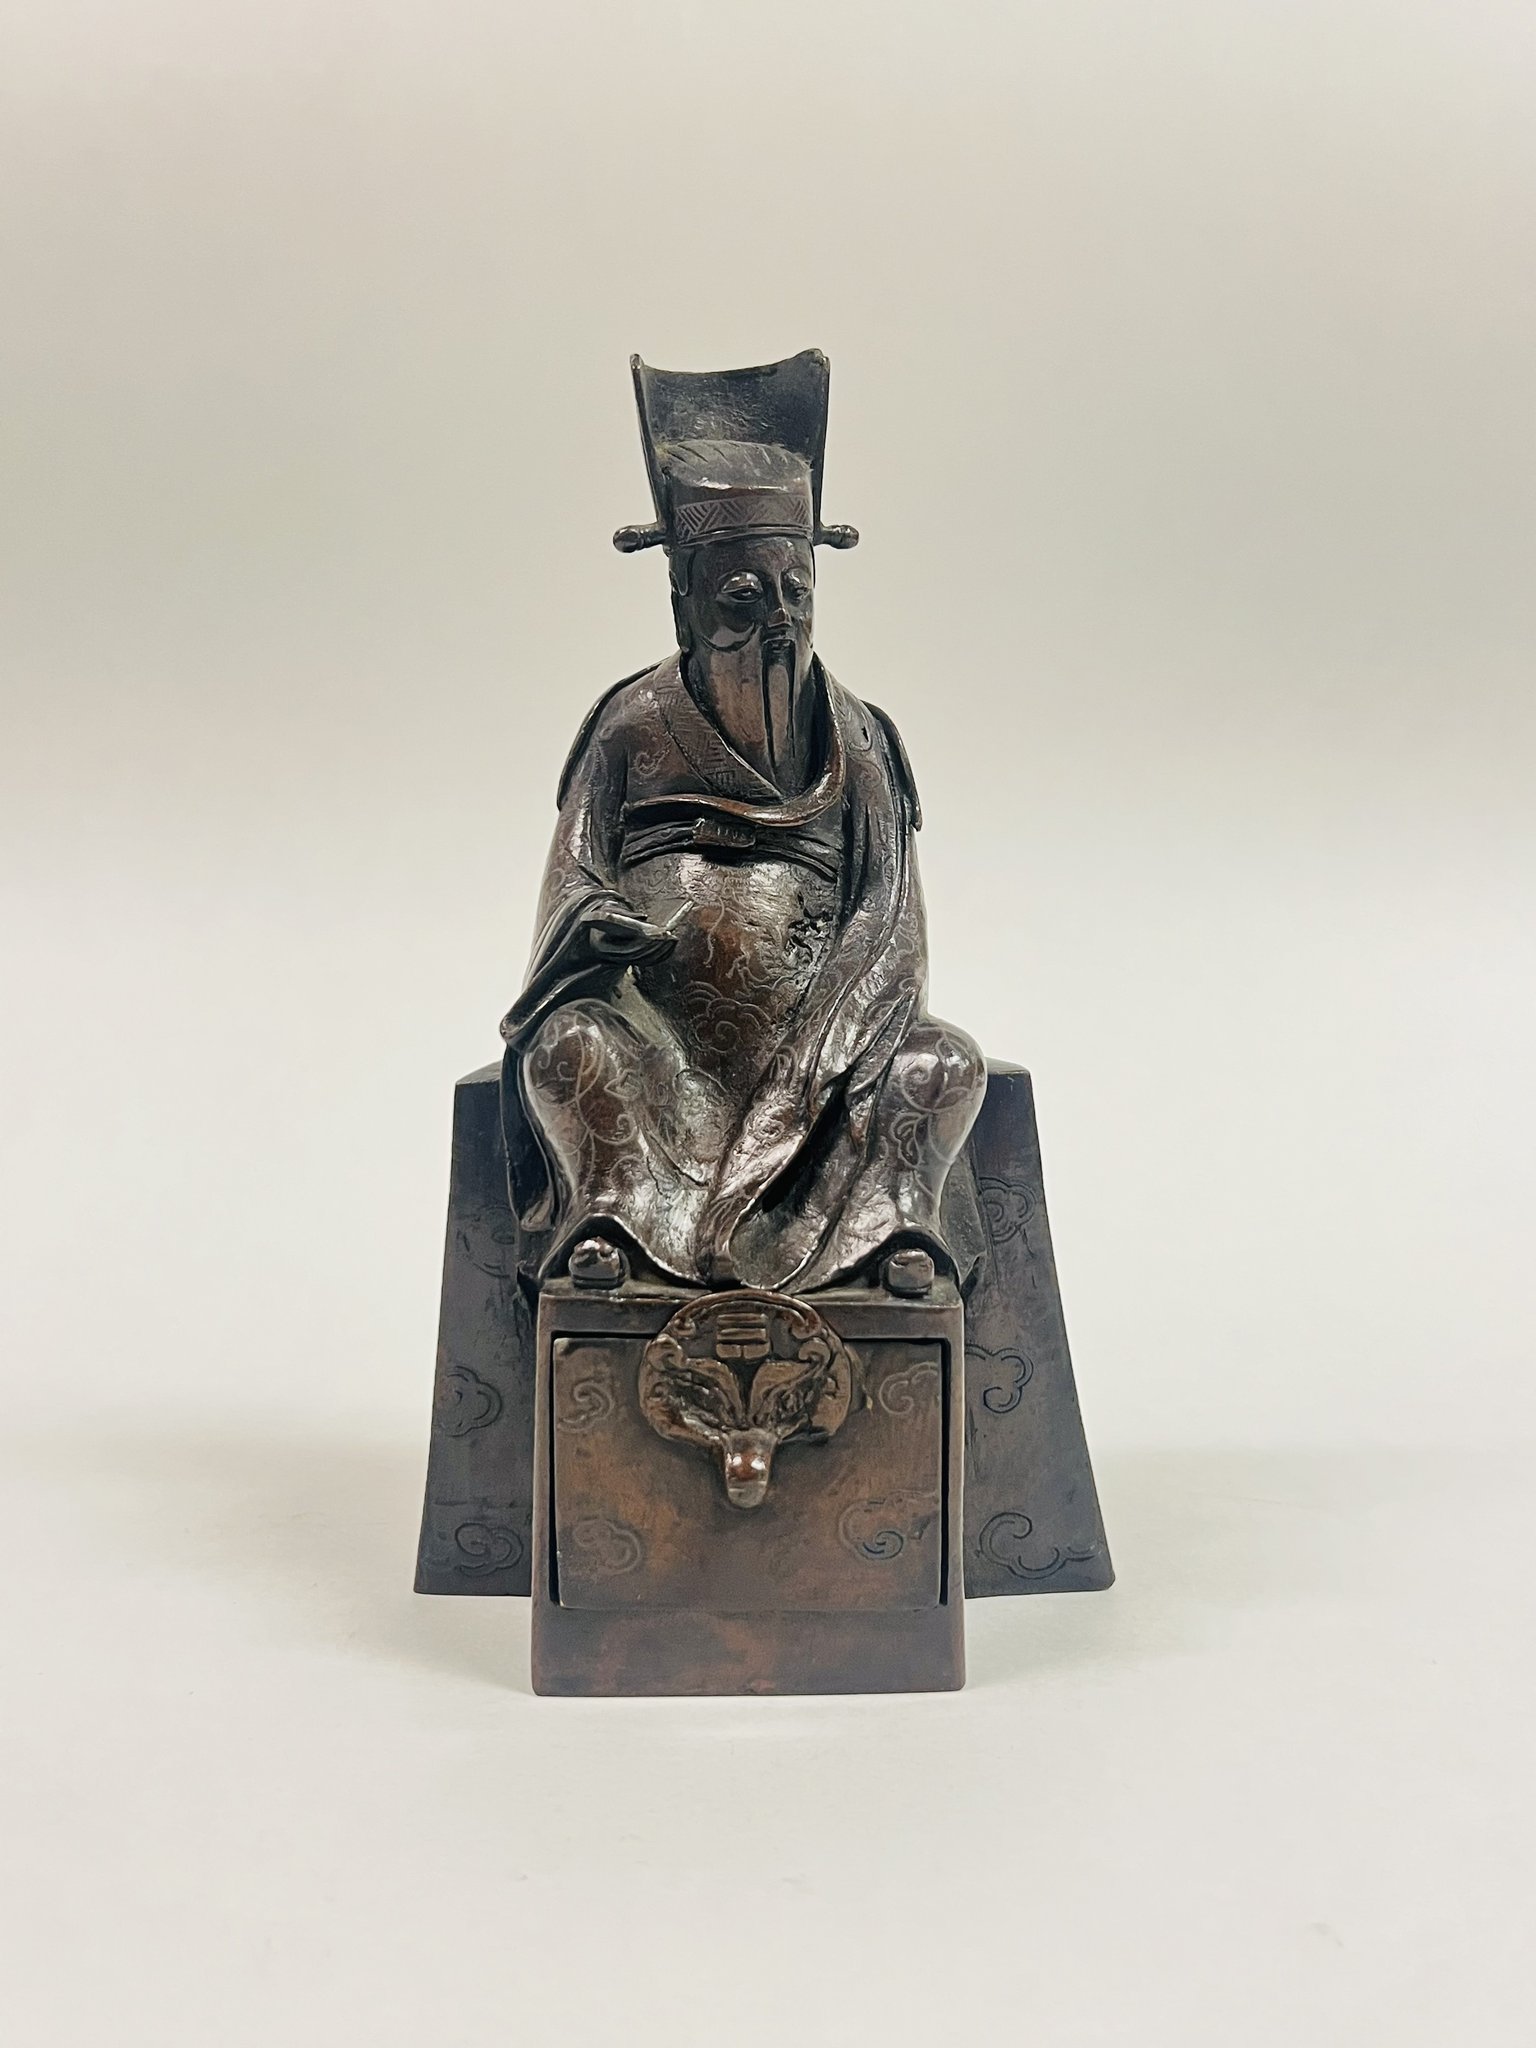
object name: incense box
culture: japanese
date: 1734-1900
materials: bronze